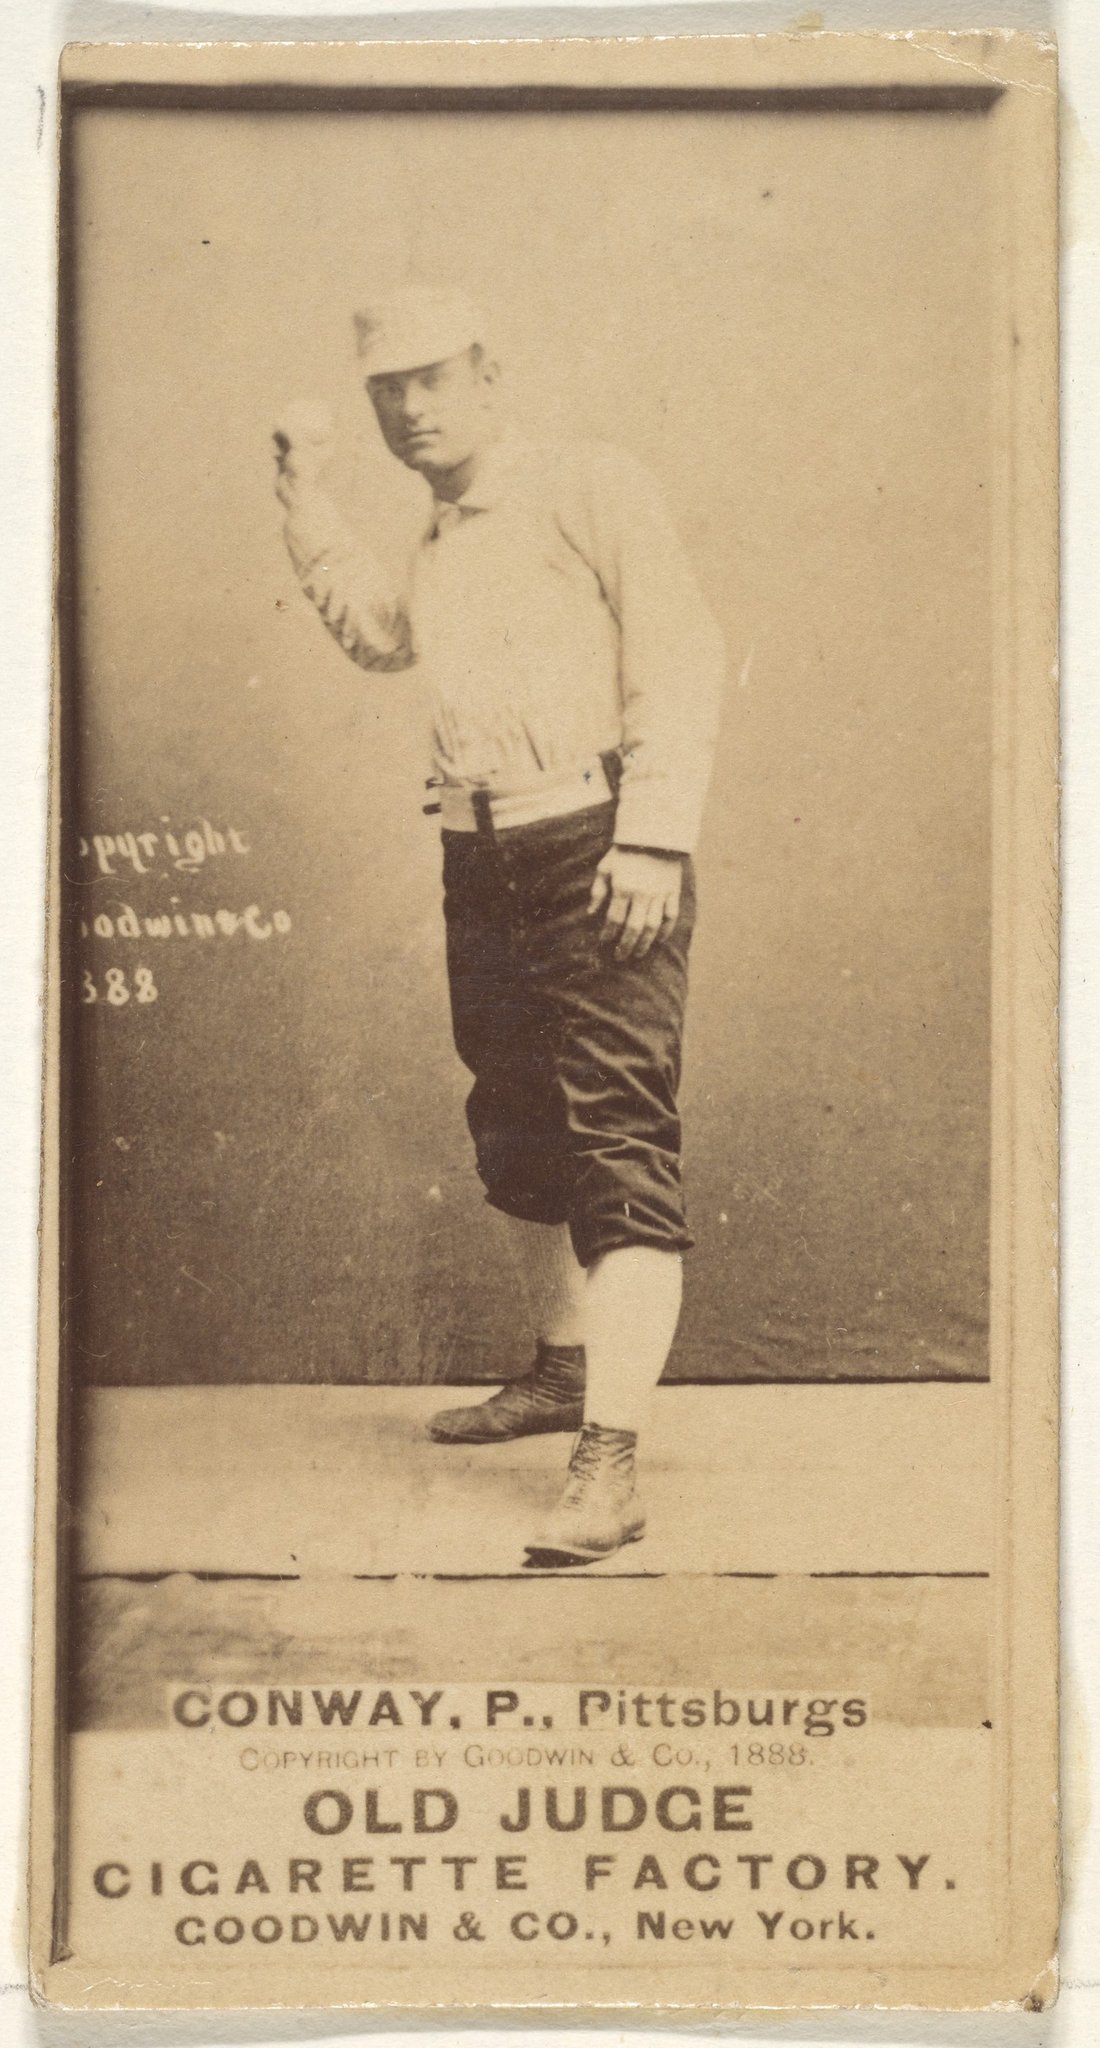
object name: baseball card, photograph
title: Pete Conway, Pitcher, Pittsburgh, from the Old Judge series (N172) for Old Judge Cigarettes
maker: goodwin & company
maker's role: publisher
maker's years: 1850-1950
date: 1888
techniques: albumen silver print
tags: men,portraits,baseball,athletes